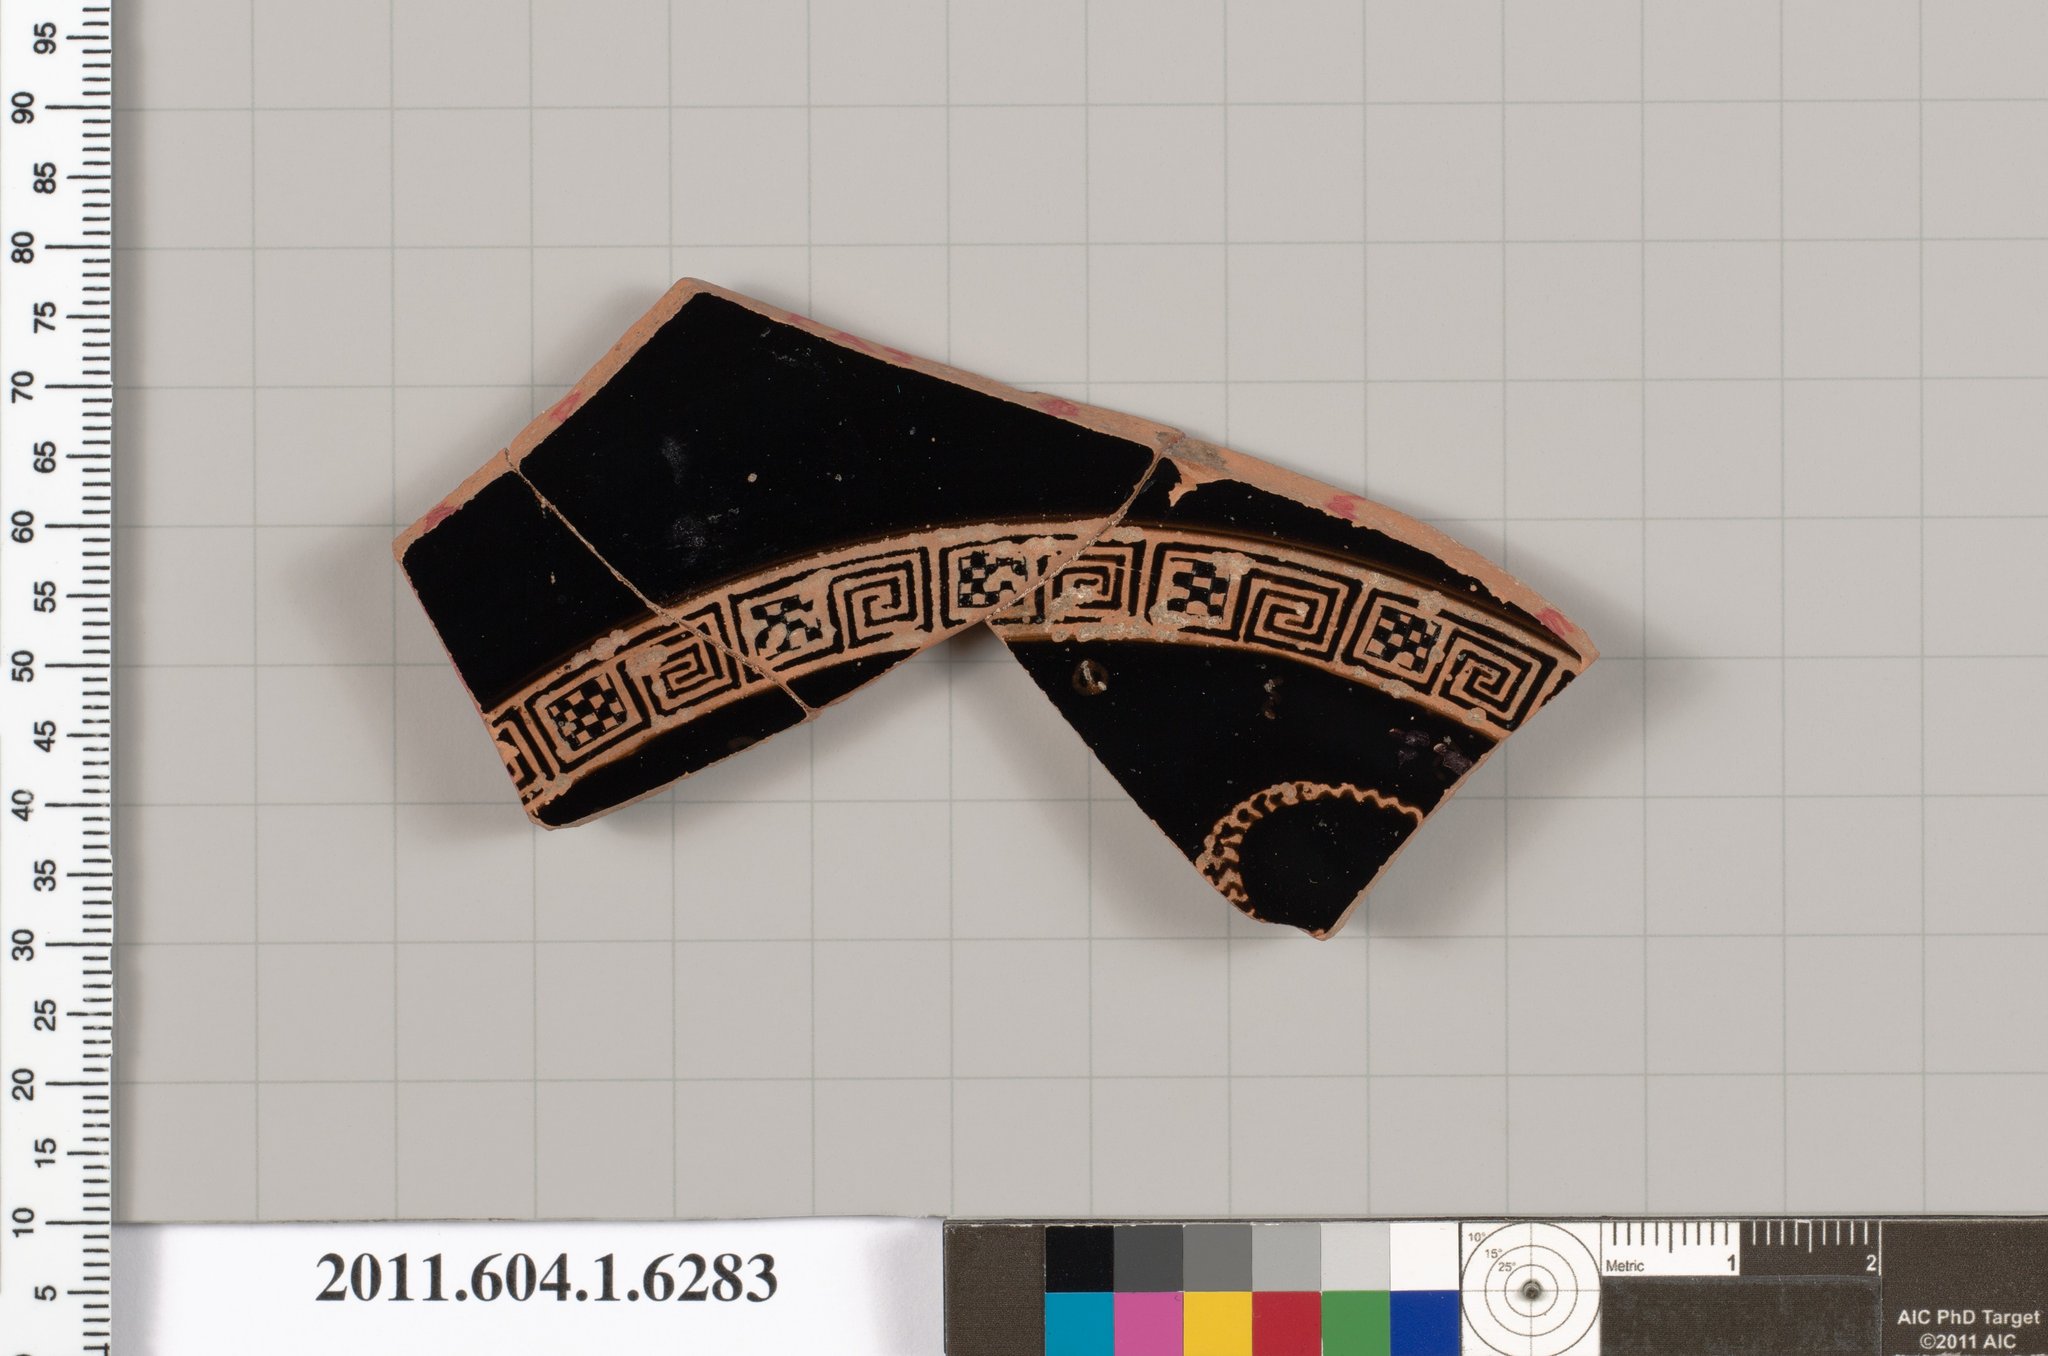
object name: kylix fragment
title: Terracotta fragment of a kylix (drinking cup)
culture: greek, attic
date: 500-480 BCE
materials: terracotta